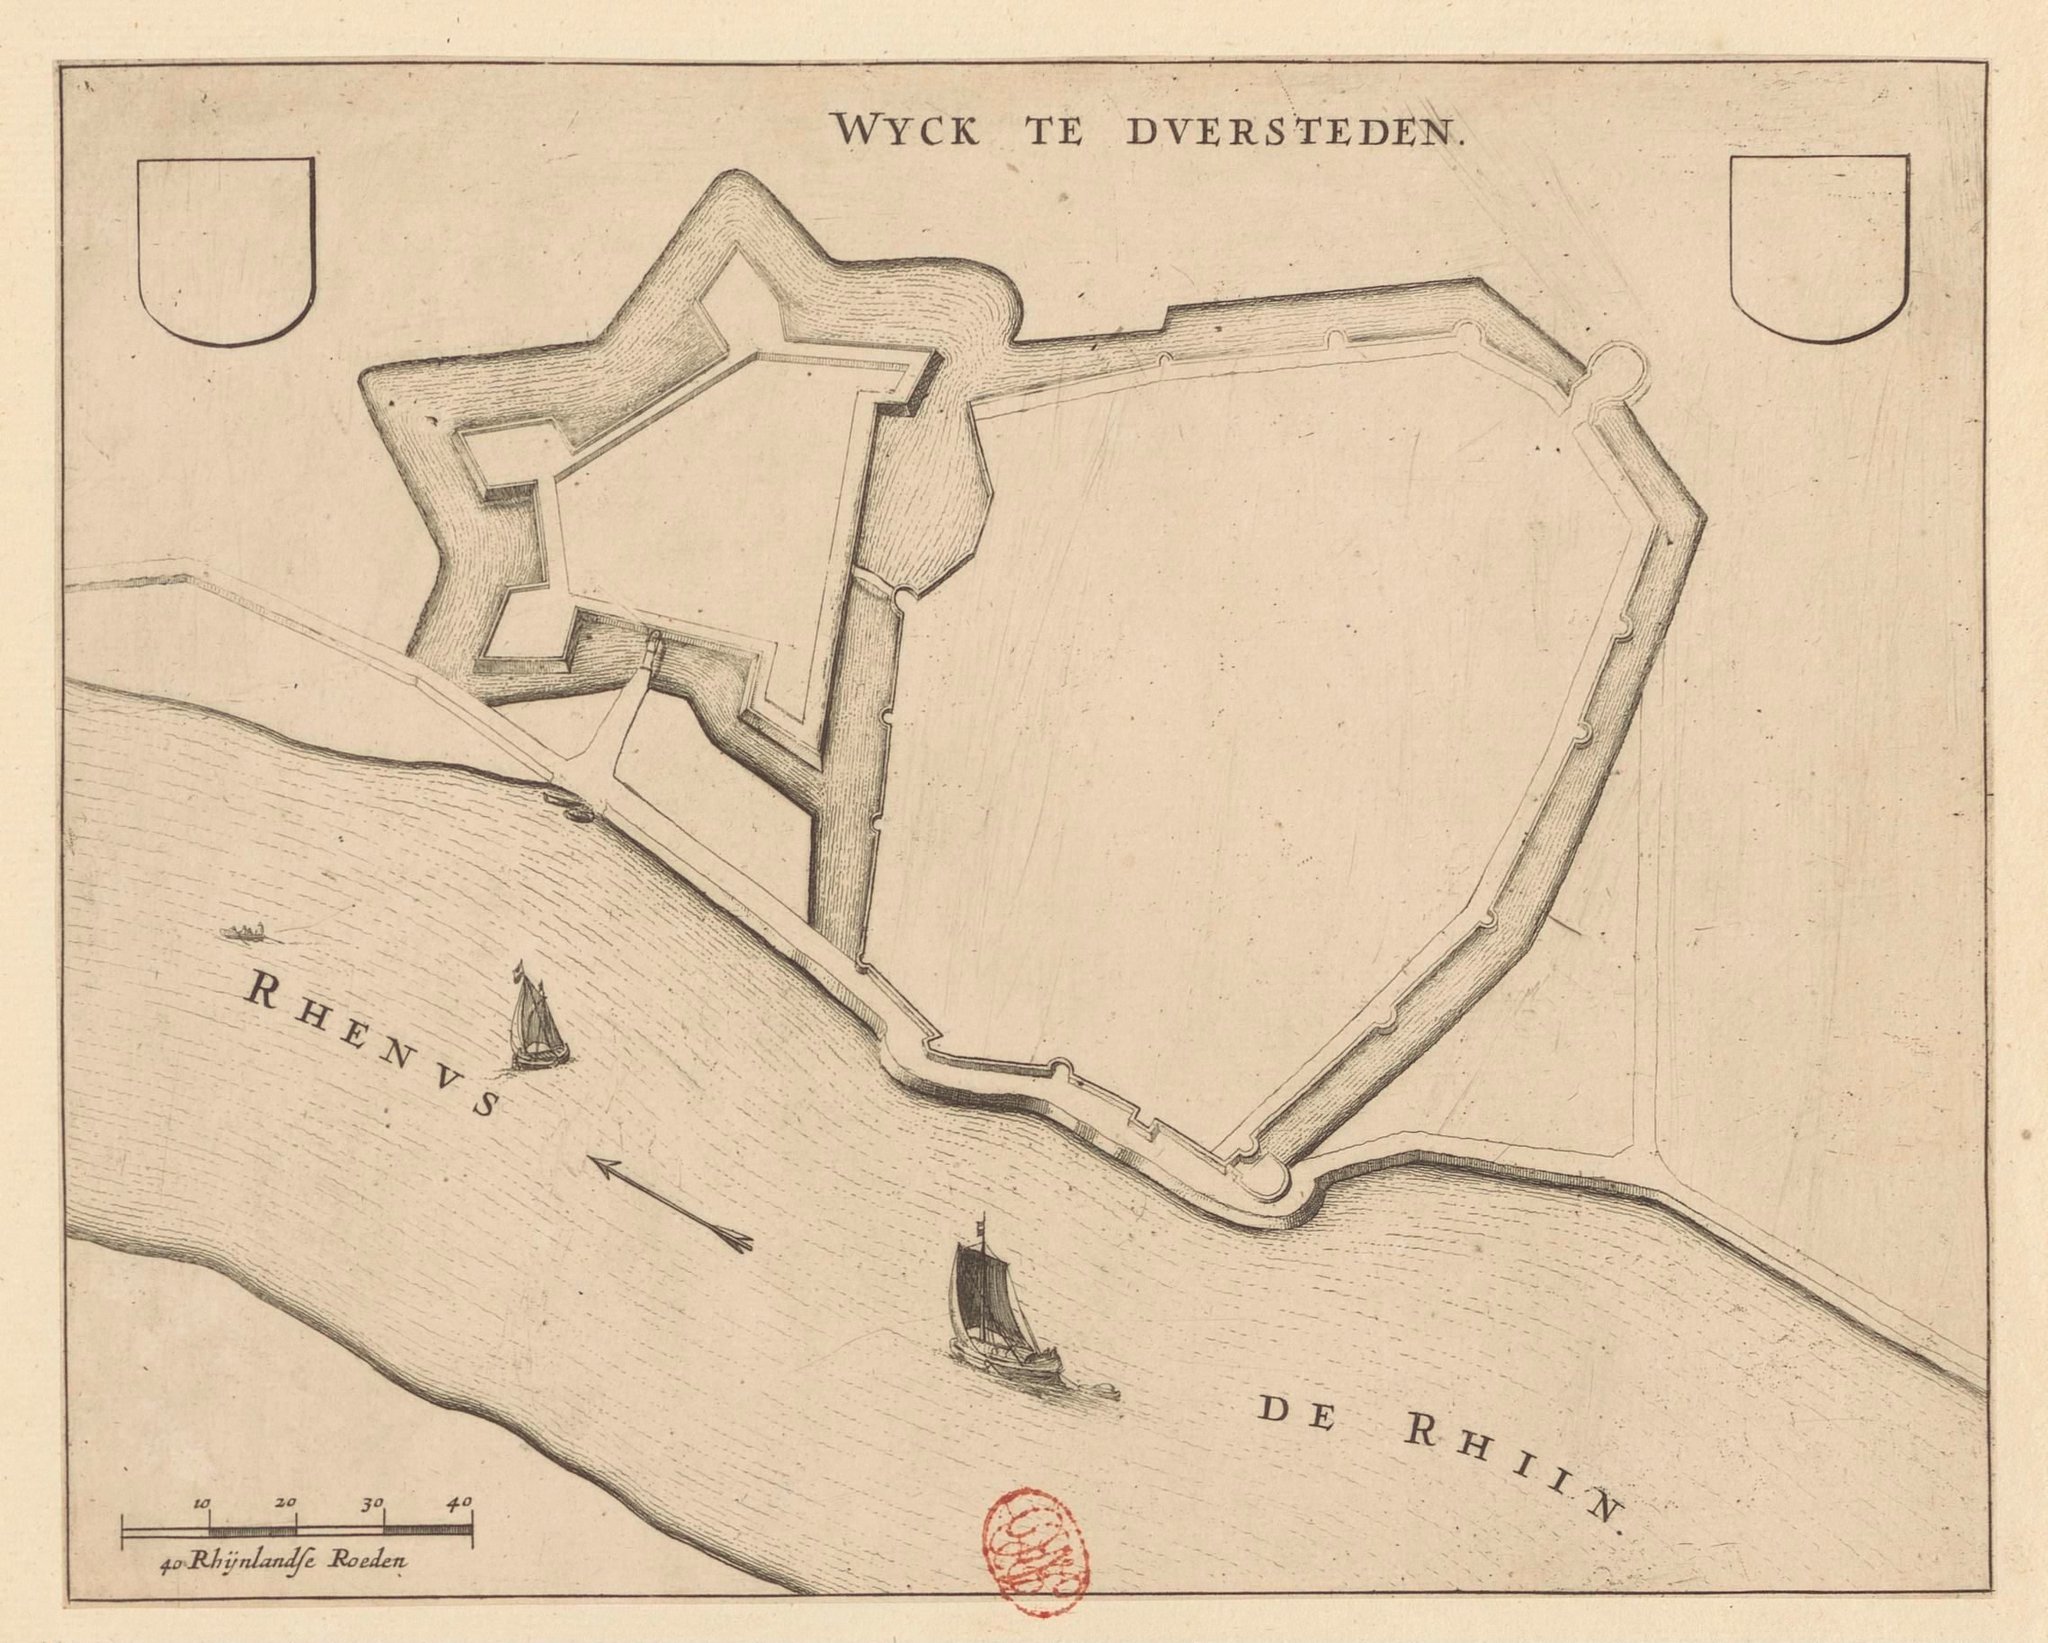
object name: print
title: Wyck te Duersteden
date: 1649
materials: paper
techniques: engraving, etching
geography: amsterdam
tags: maps of cities, wijk bij duurstede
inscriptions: collector's mark: Lugt 195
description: Dit object is een uitgeknipt of -gesneden deel van een grotere prent met een vestingplattegrond van Wijk bij Duurstede en een plattegrond van Montfoort (zie gerelateerde objecten). Deze prent is ook gebruikt in: Blaeu, Johannes Willemszoon. Novum ac magnum theatrum urbium Belgicae (...). 2 delen. 1e druk. Amsterdam: Johannes Willemszoon Blaeu, 1649, dl. 1.